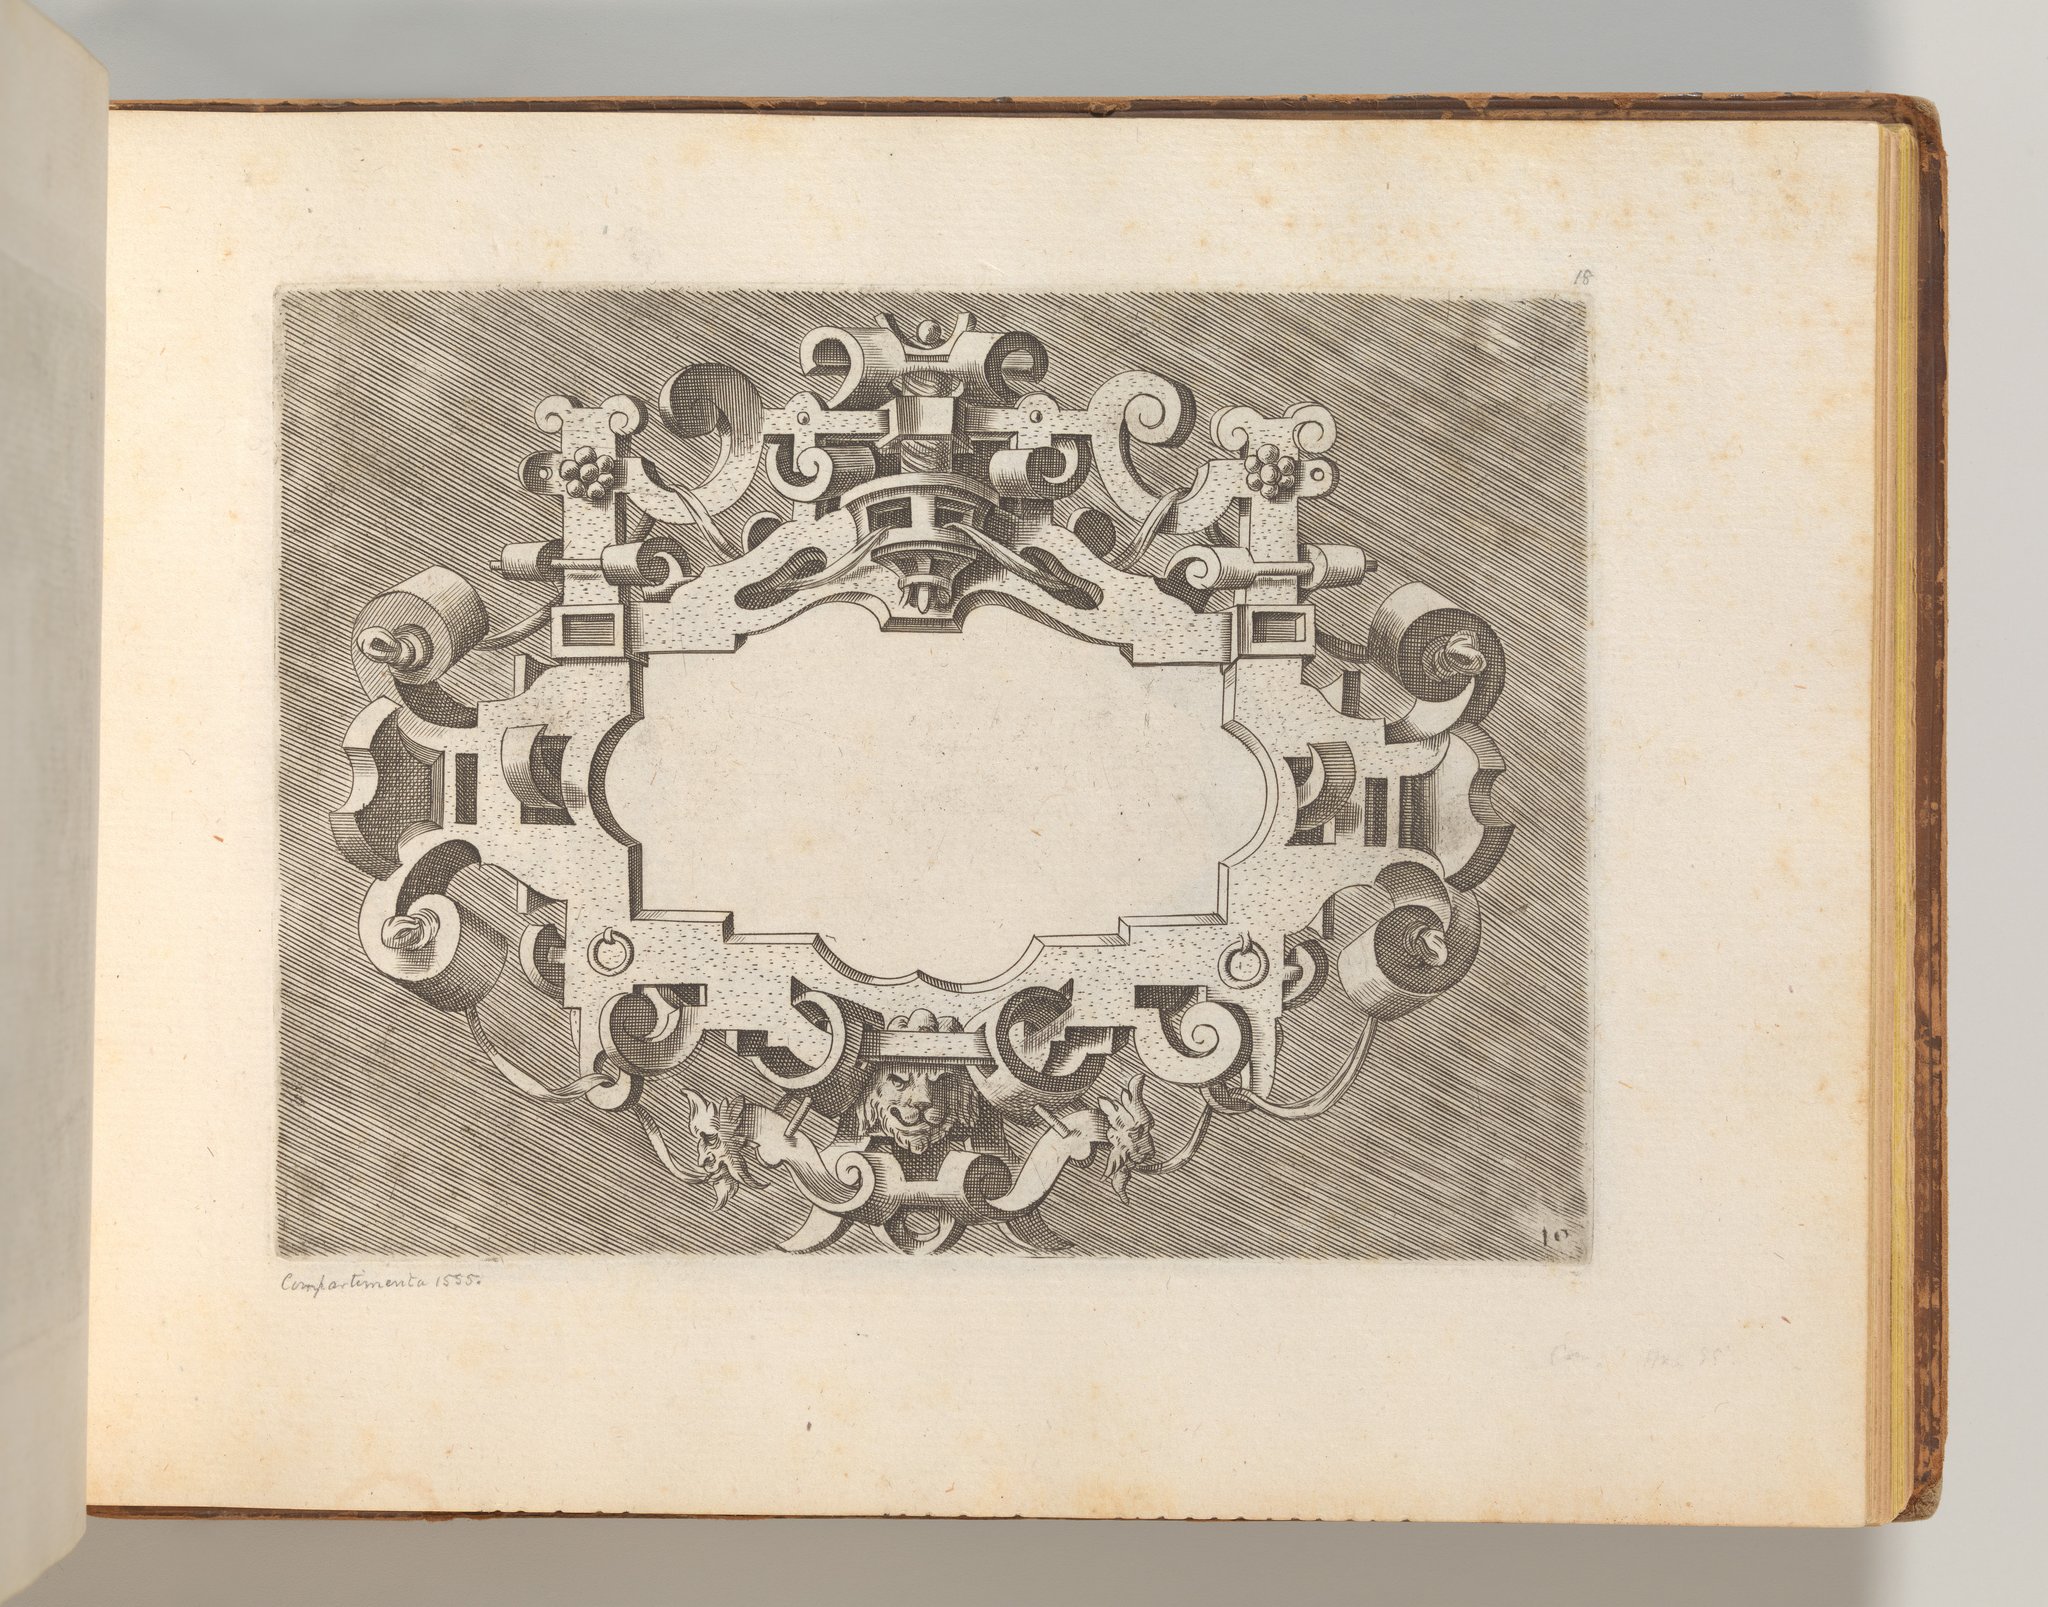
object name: album print ornament architecture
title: Targhe ed altri ornati di varie e capricciose invenzioni (Cartouches and other ornaments of various and capricious invention, page 21)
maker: hans vredeman de vries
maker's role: artist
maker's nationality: netherlandish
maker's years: 1527-1606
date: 1773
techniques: engraving, etching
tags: cartouches